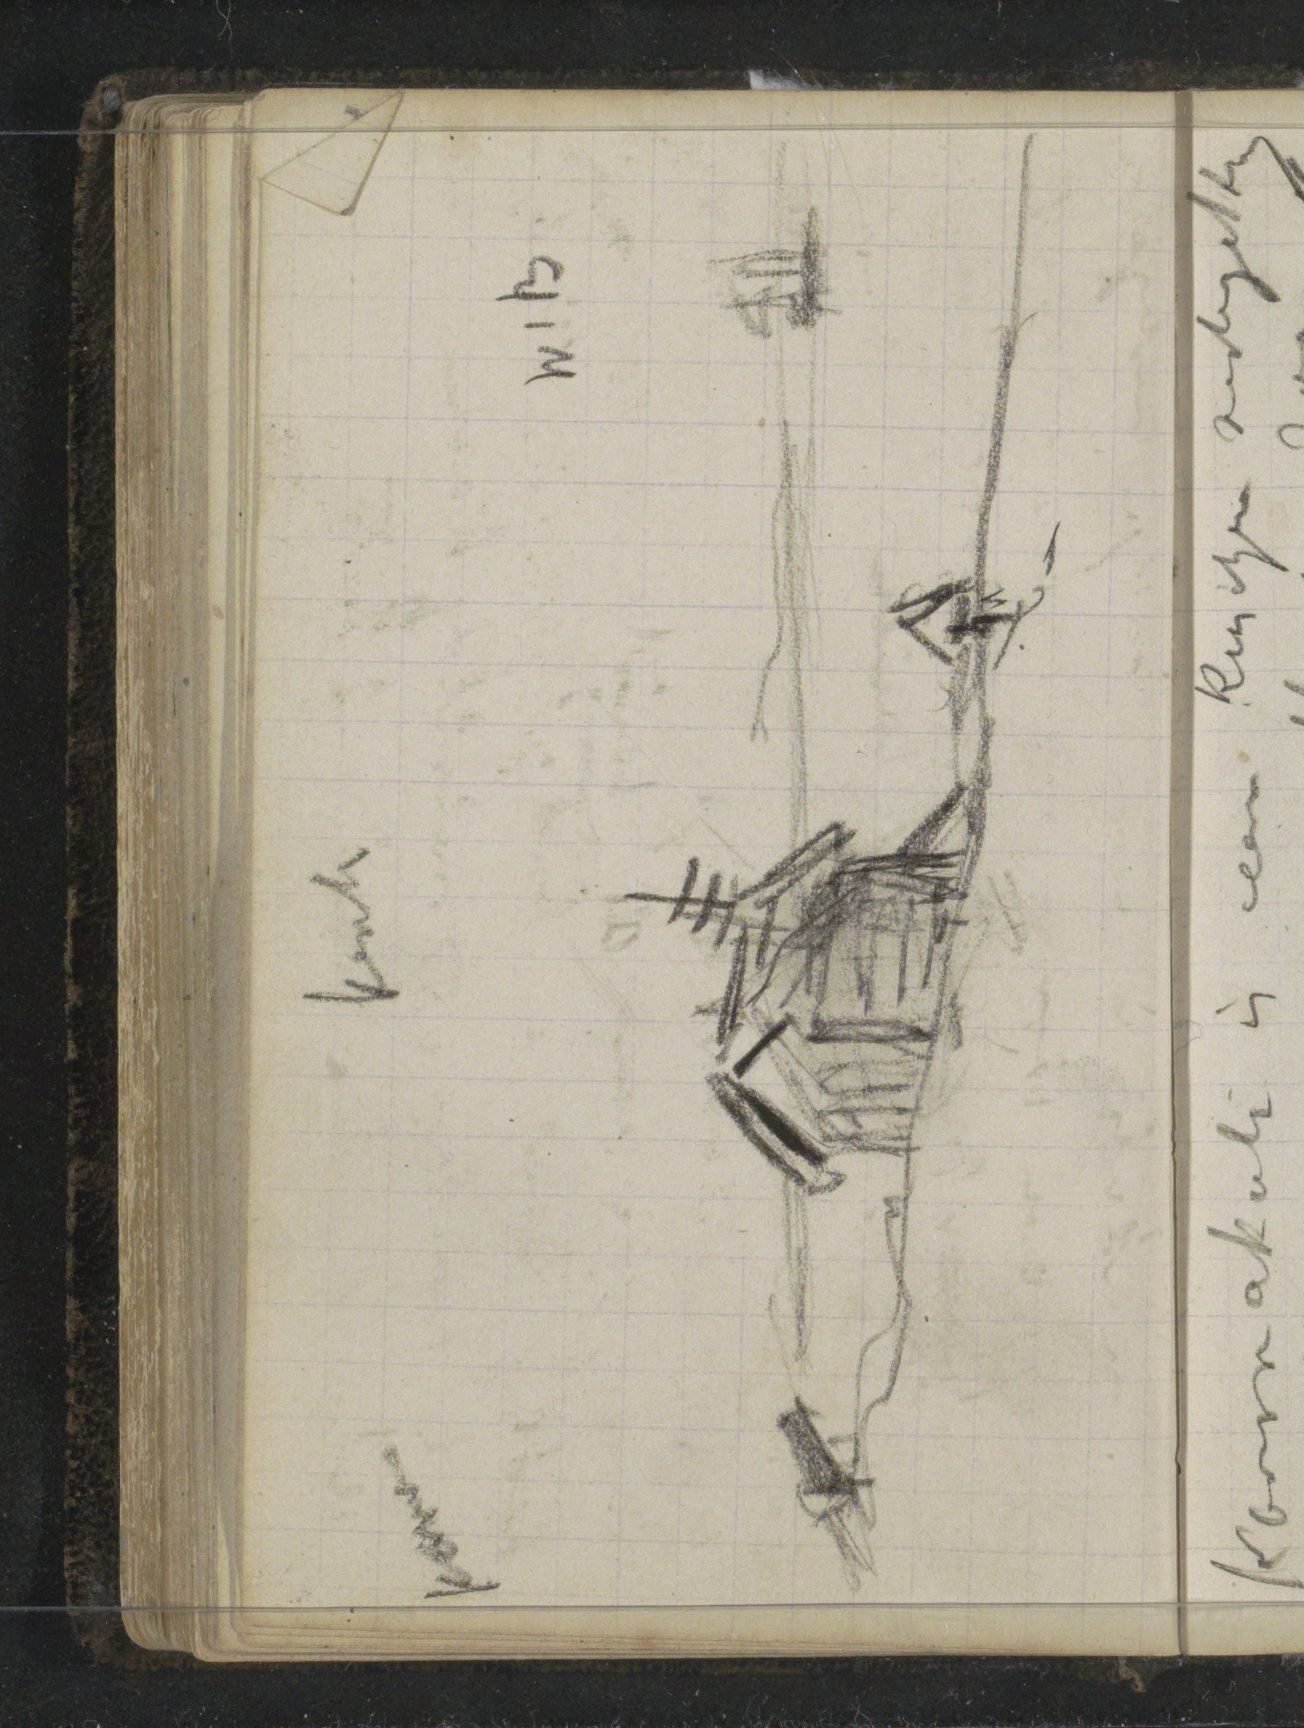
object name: sketchbook leaf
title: Kerk te Malye Karmakuly, Nova Zembla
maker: louis apol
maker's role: draughtsman, painter, print maker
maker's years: 1850-1936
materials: chalk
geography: malye karmakuly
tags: coast (in polar regions), church (exterior) - qq - small church, chapel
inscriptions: annotation: ‘[...] / kerk / [...]’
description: Op zee een zeilschip. Blad 71 verso uit een schetsboek met 110 bladen betekend tijdens de expeditie naar Nova Zembla in 1880.